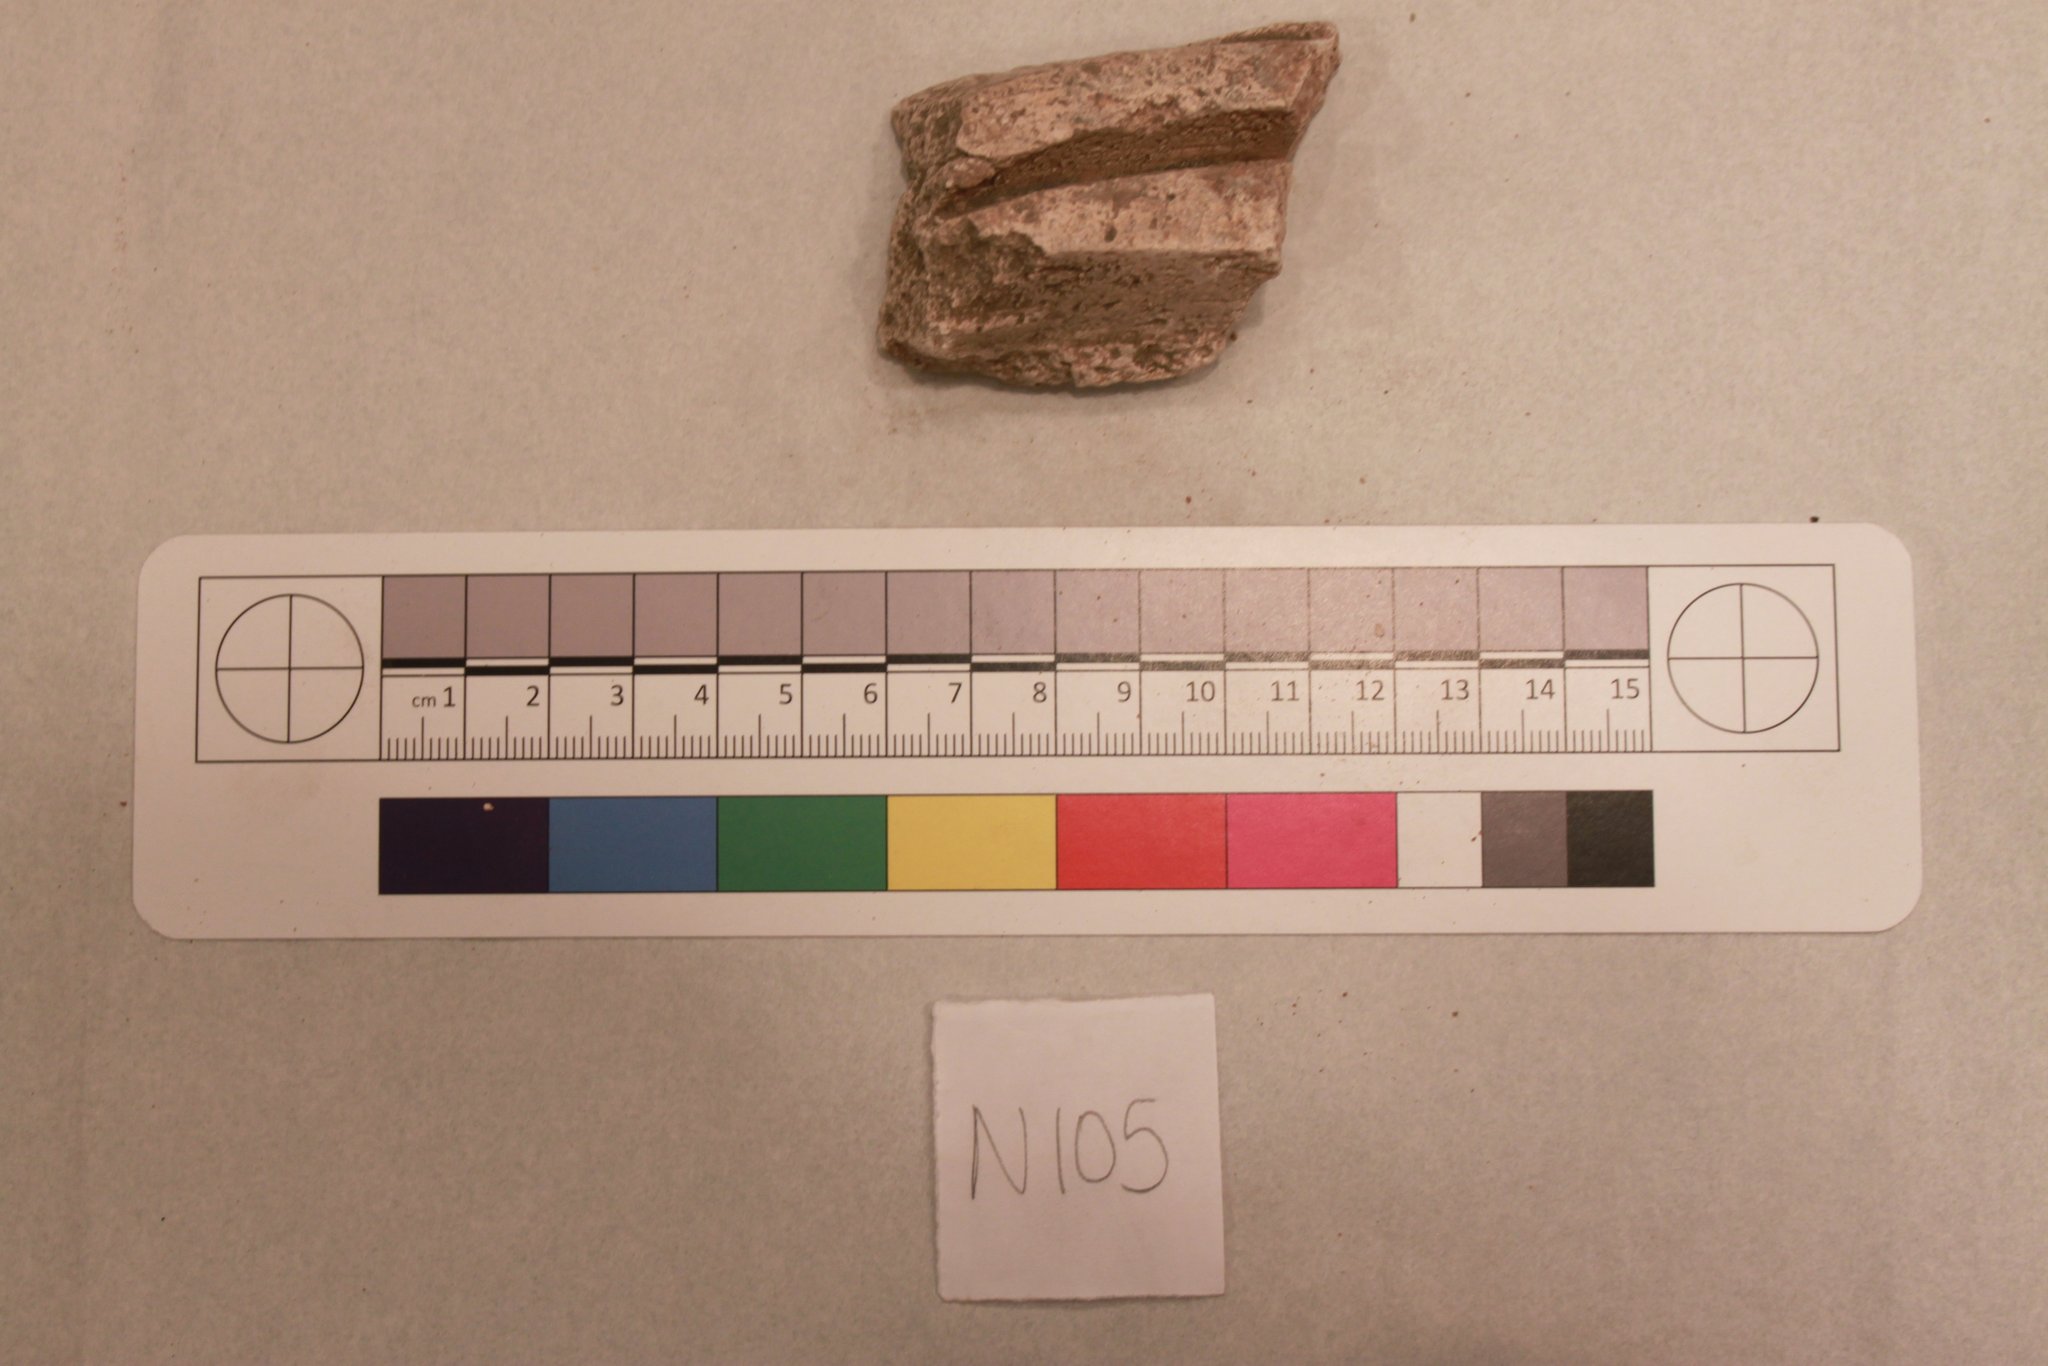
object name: fragment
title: Stucco Fragment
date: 701-1200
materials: plaster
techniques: carving, painting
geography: iran